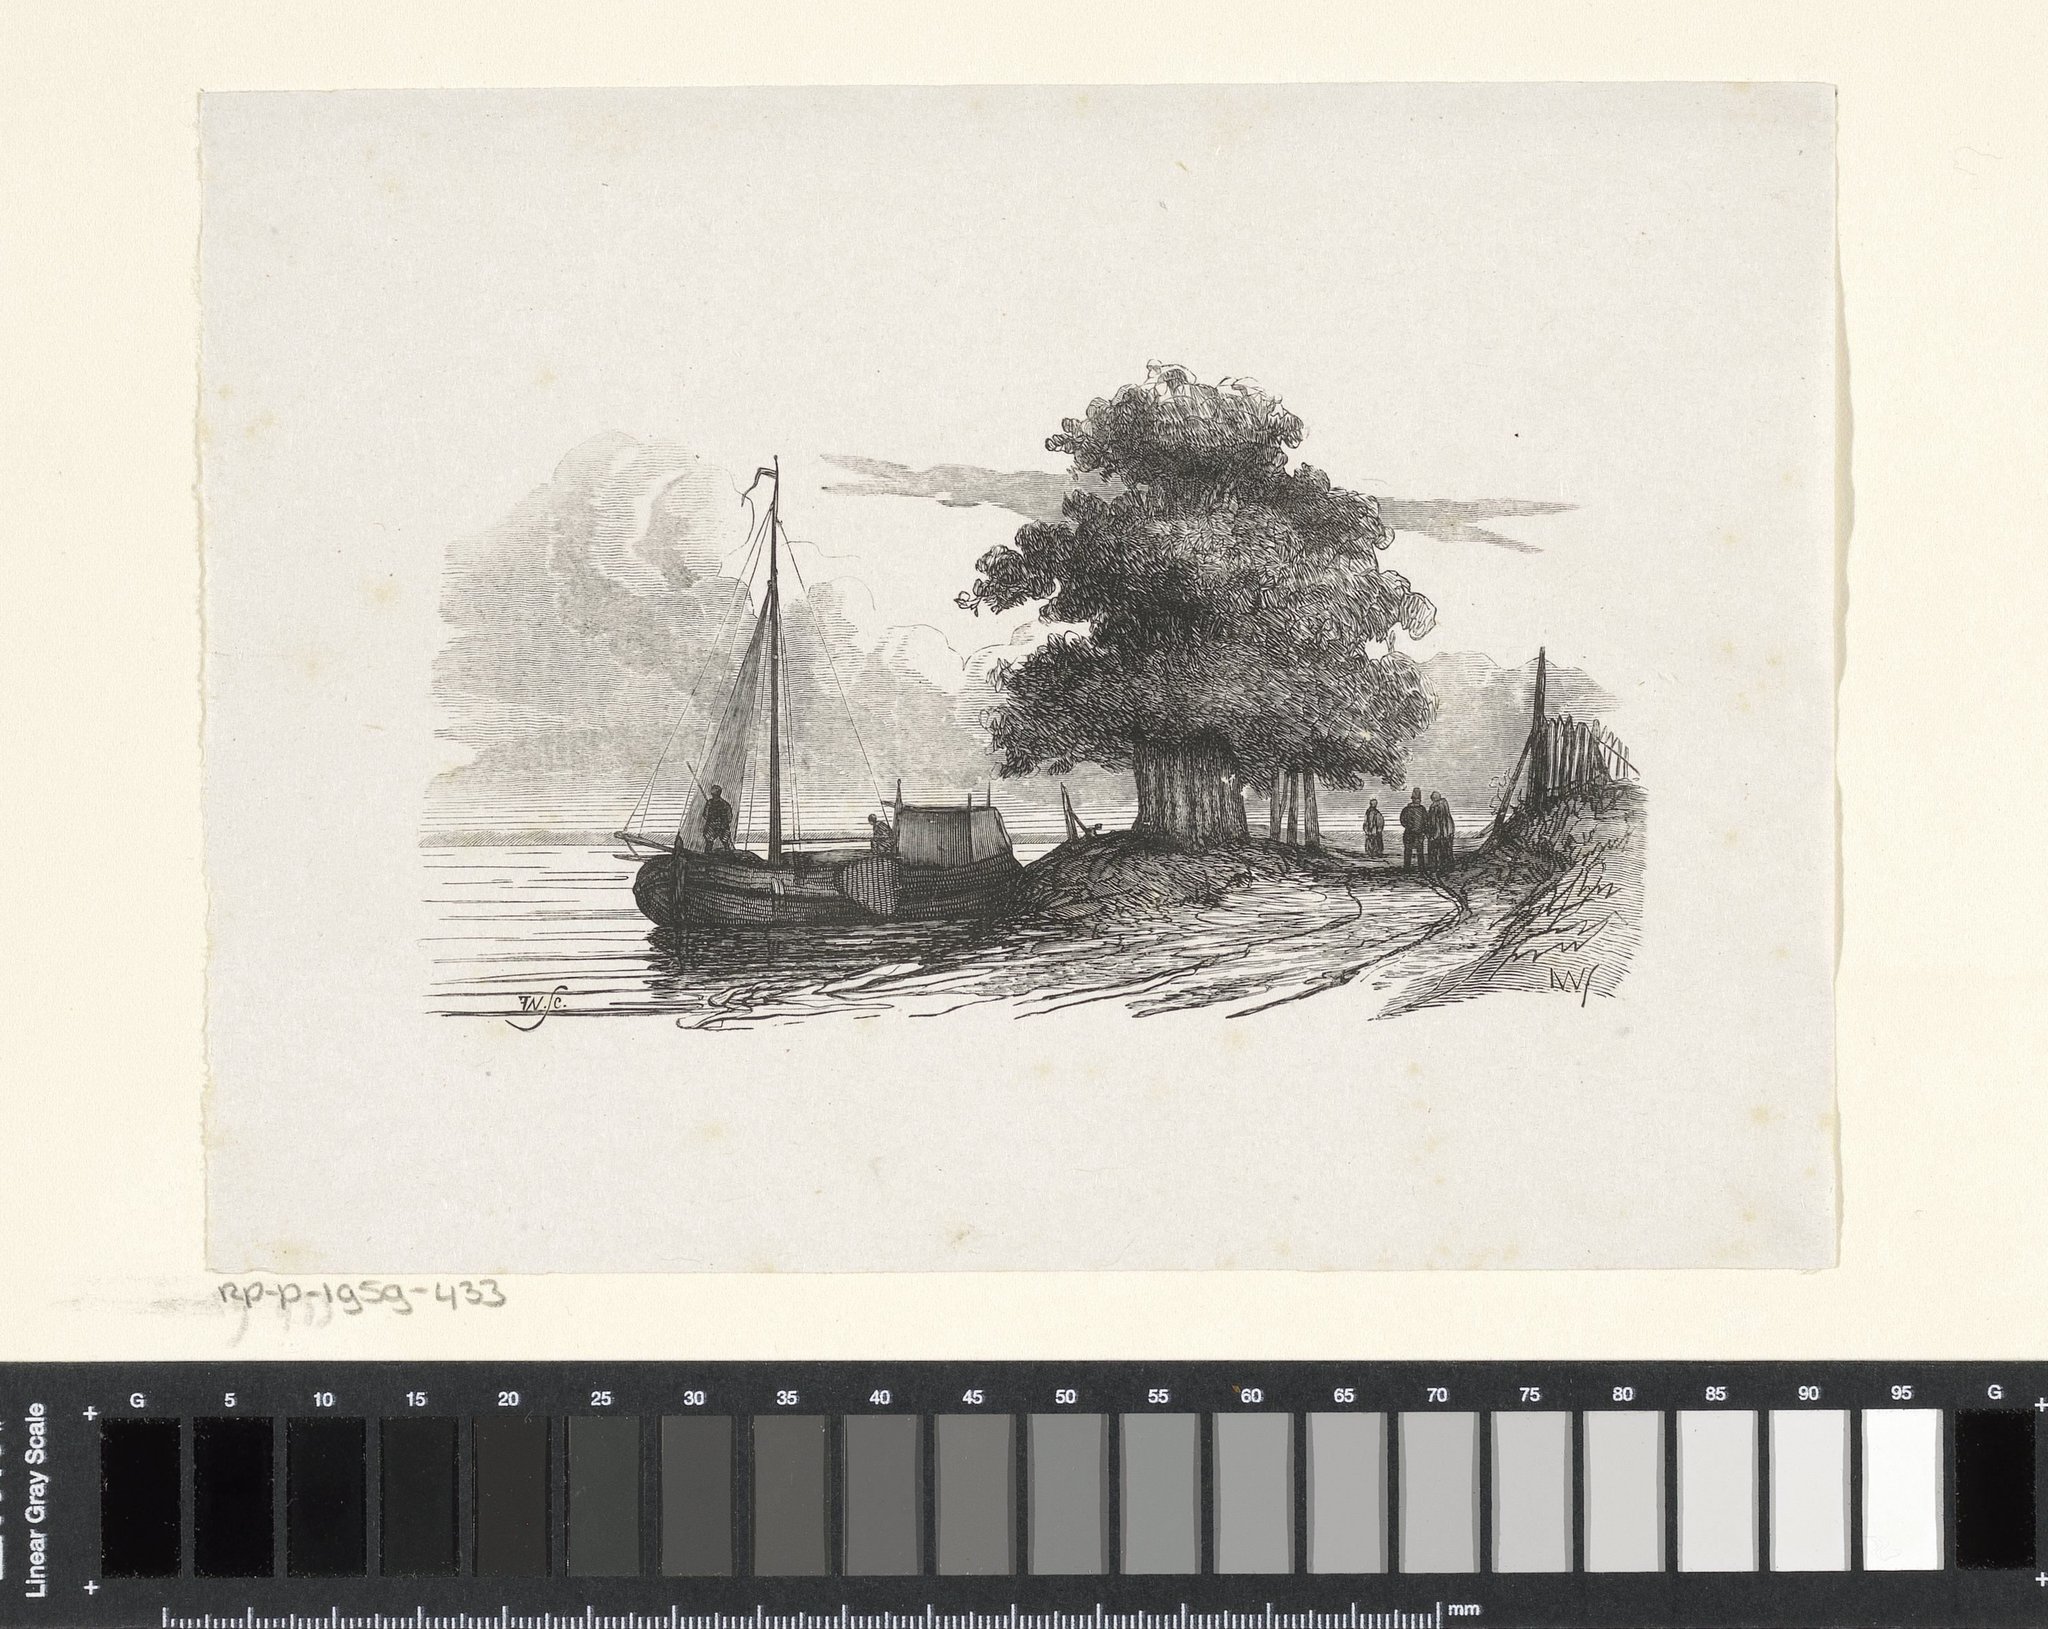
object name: print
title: Rivierlandschap met een tjalk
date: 1838-1887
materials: paper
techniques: engraving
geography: the hague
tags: sailing-ship, sailing-boat, river (+ landscape with figures, staffage)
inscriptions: collector's mark: Lugt 2228